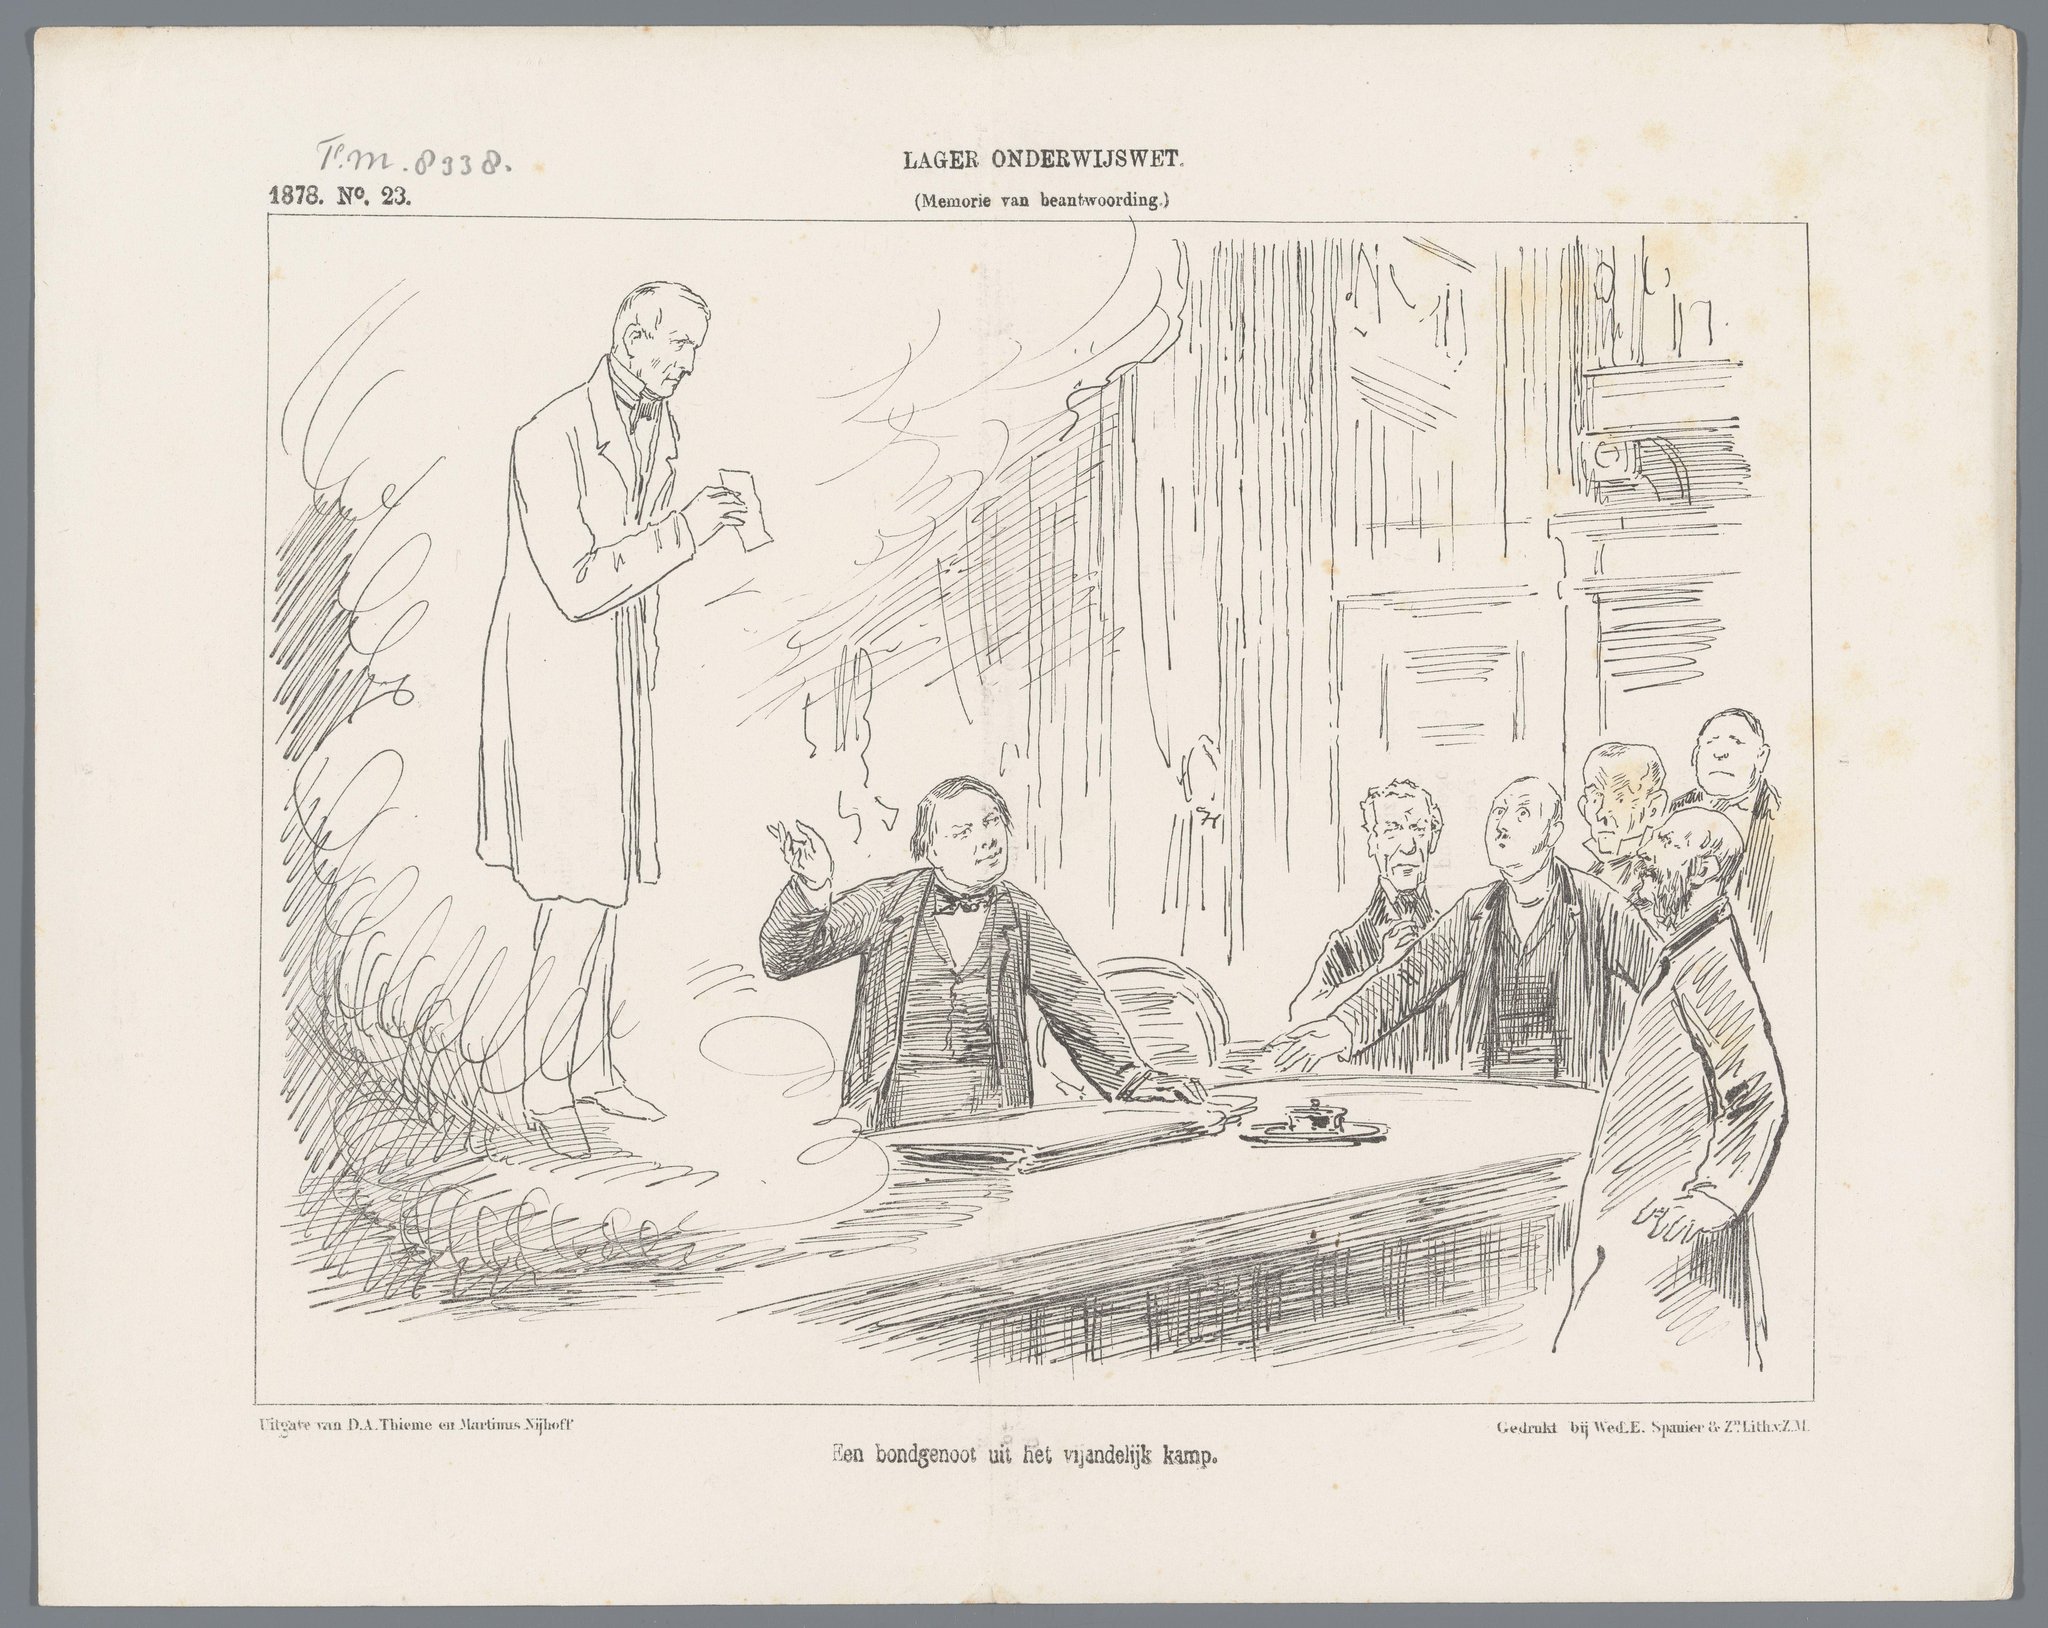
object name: cartoon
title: Lager onderwijswet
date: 1878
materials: paper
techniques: lithograph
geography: arnhem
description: Spotprent. Plaat verschenen bij het weekblad De Nederlandsche Spectator, nr. 23, 1878.